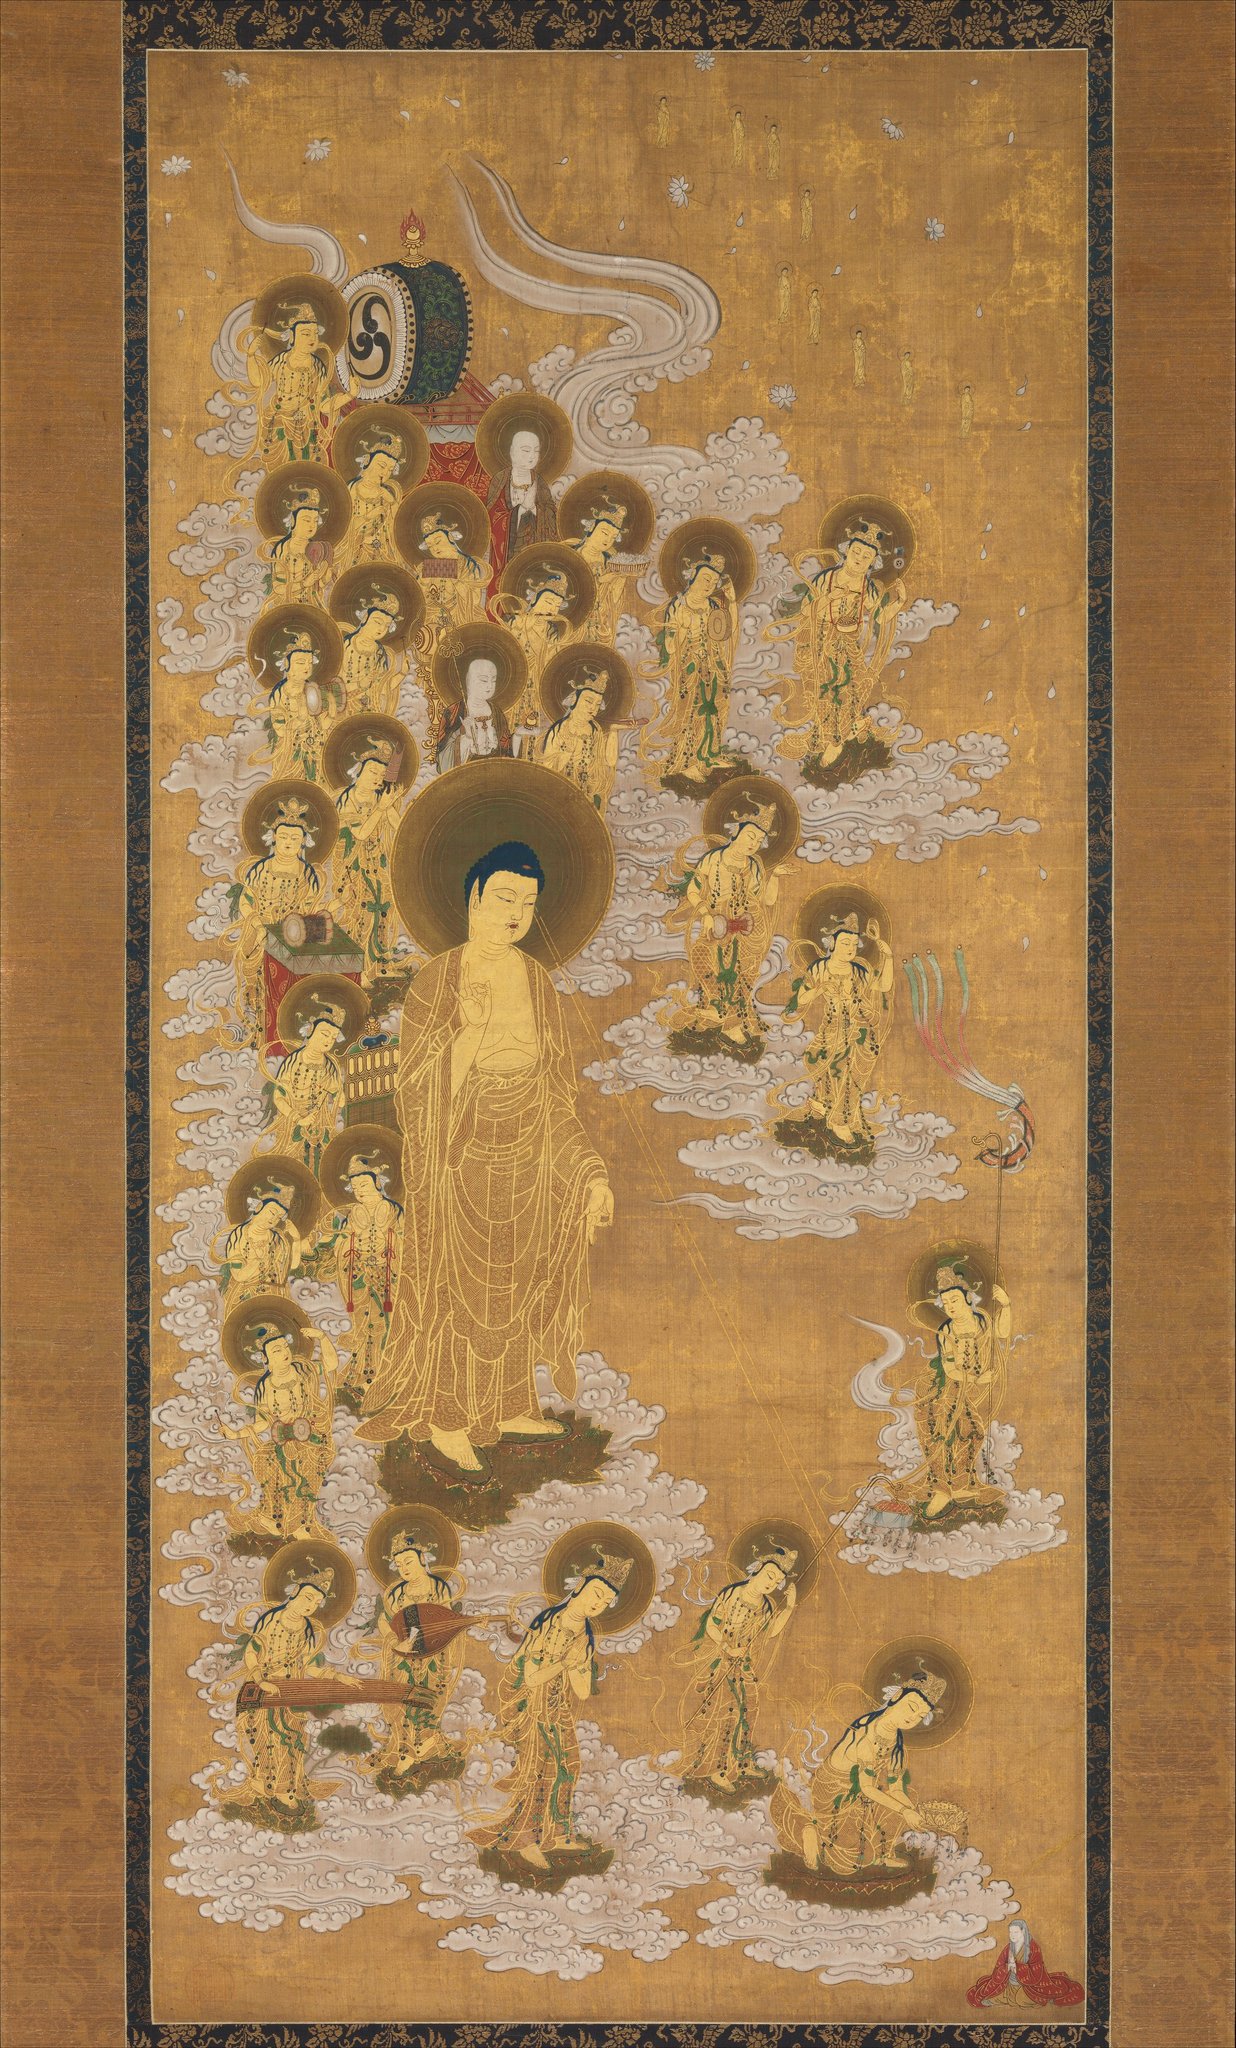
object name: hanging scroll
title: Welcoming Descent of Amida Buddha and Twenty-five Bodhisattvas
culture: japanese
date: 1668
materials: gold, ink, silk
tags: bodhisattvas,buddha